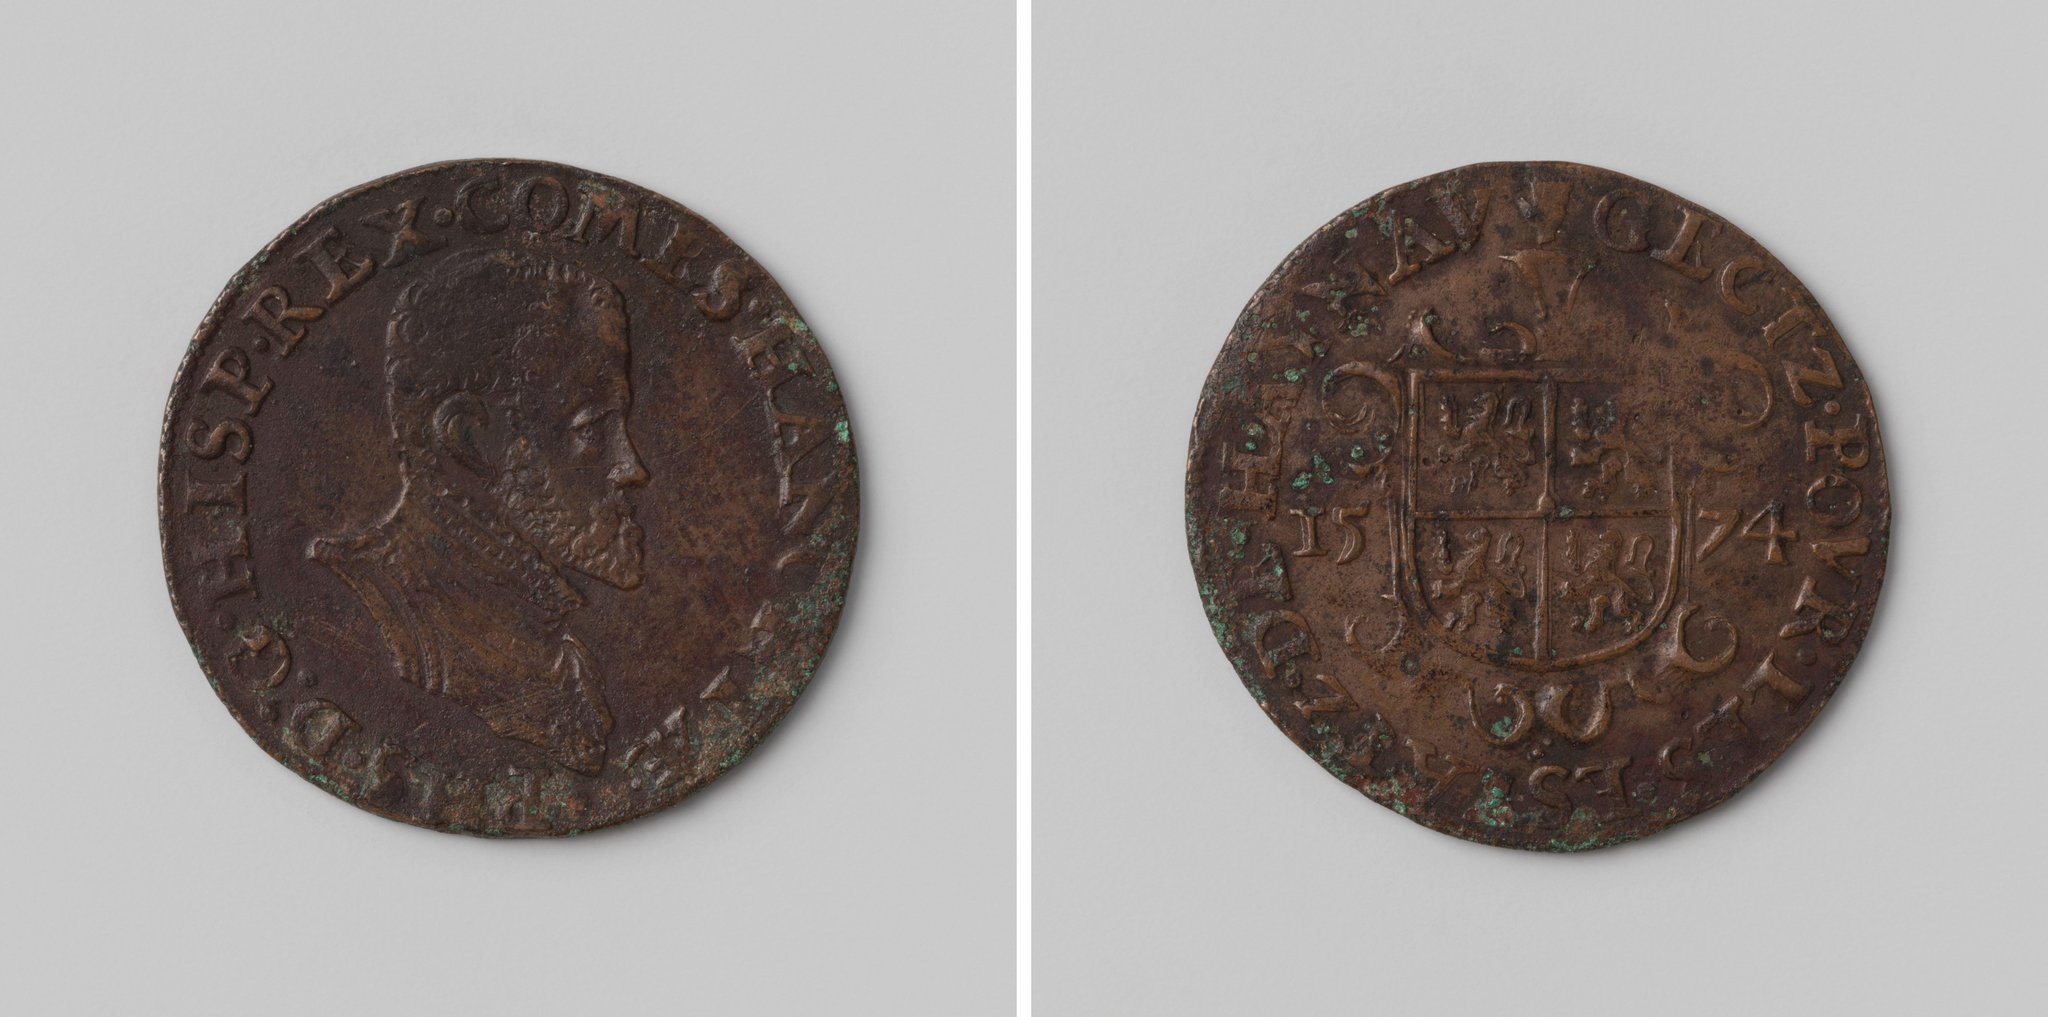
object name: jeton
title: Filips II, koning van Spanje, rekenpenning van de Staten van Henegouwen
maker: Anonymous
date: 1574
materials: copper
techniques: striking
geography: antwerp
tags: philip ii of spain, henegouwen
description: Koperen penning. Voorzijde: borststuk man binnen omschrift. Keerzijde: wapenschild in cartouche tussen jaartal binnen omschrift